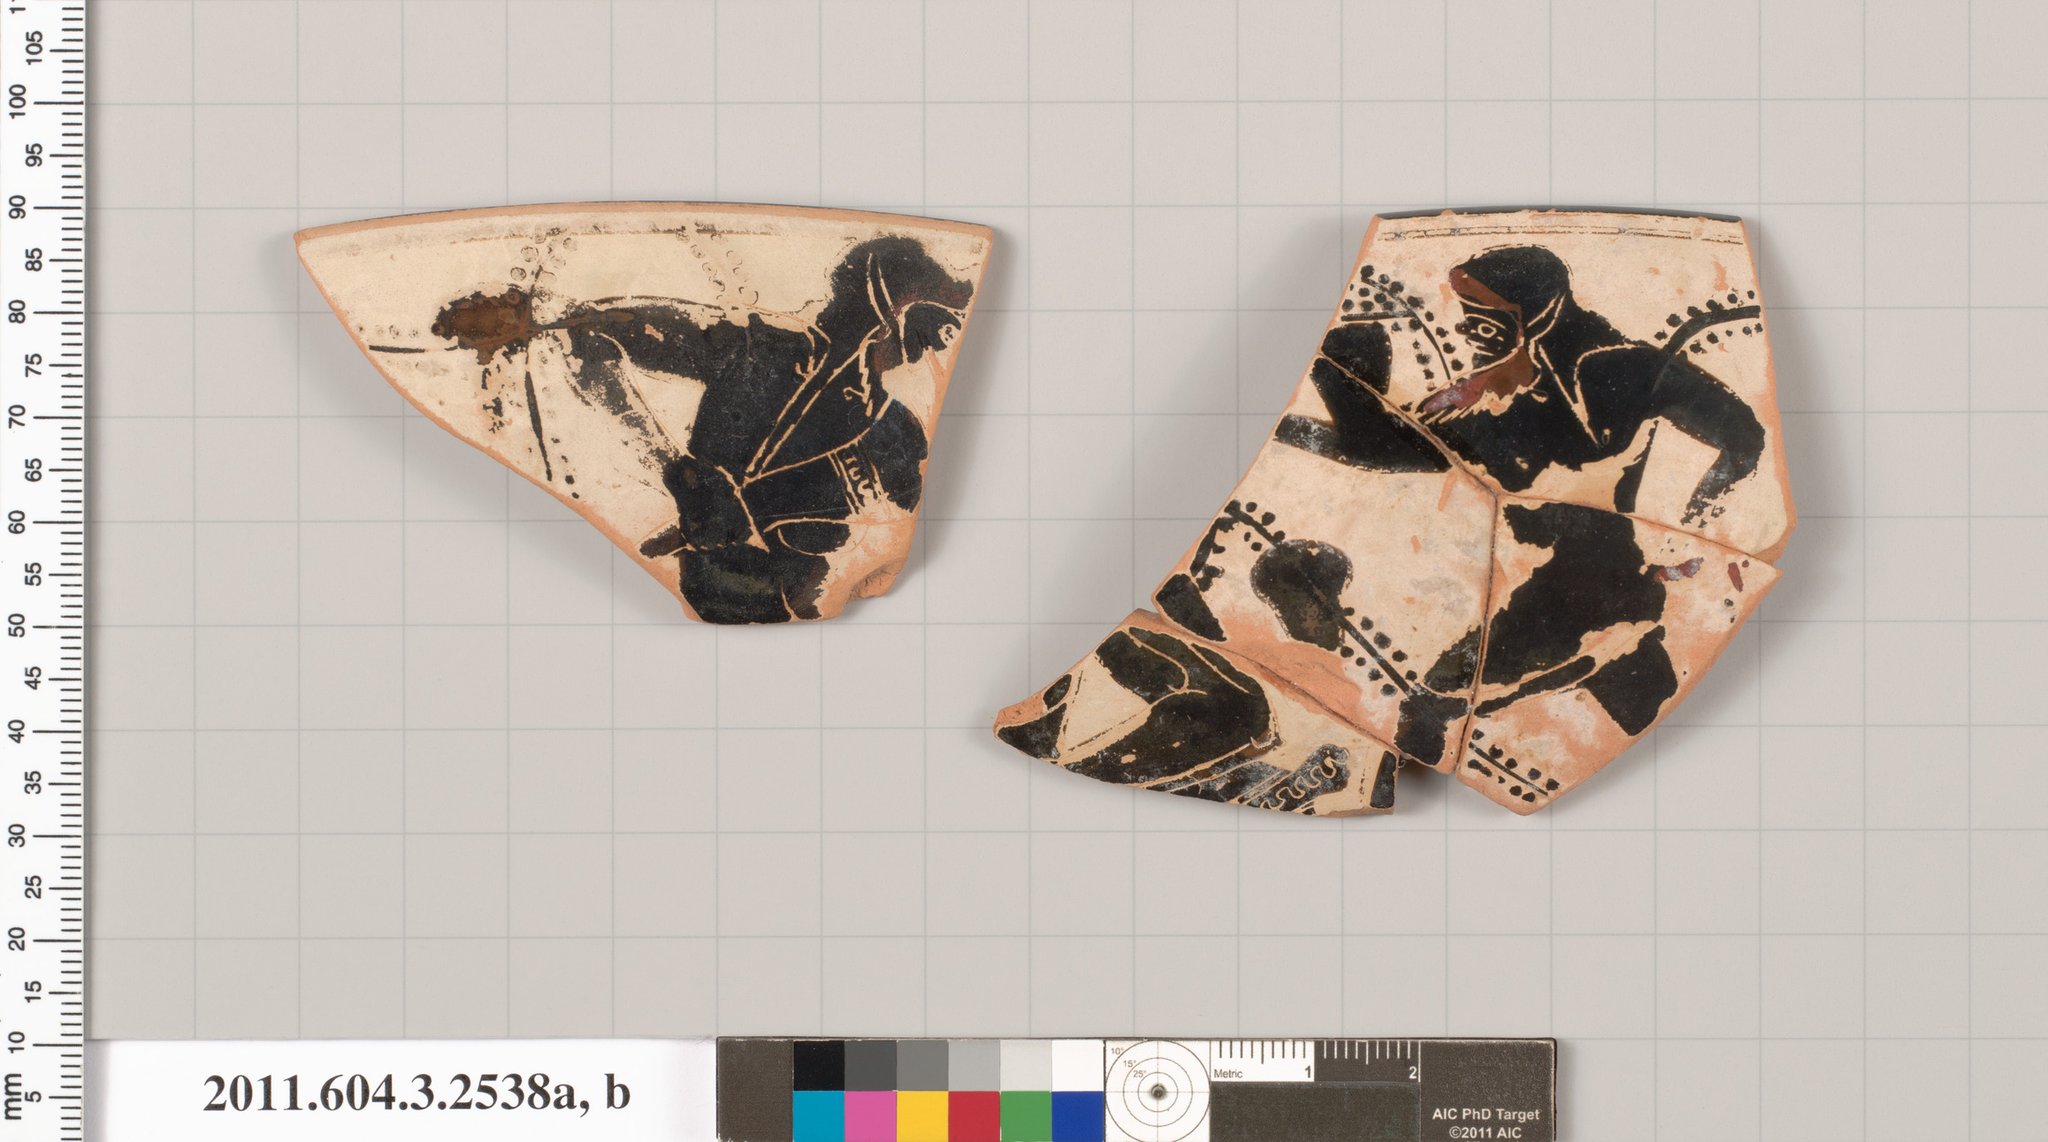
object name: kylix fragment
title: Terracotta rim fragments of a kylix (drinking cup)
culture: greek, attic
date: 534-468 BCE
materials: terracotta